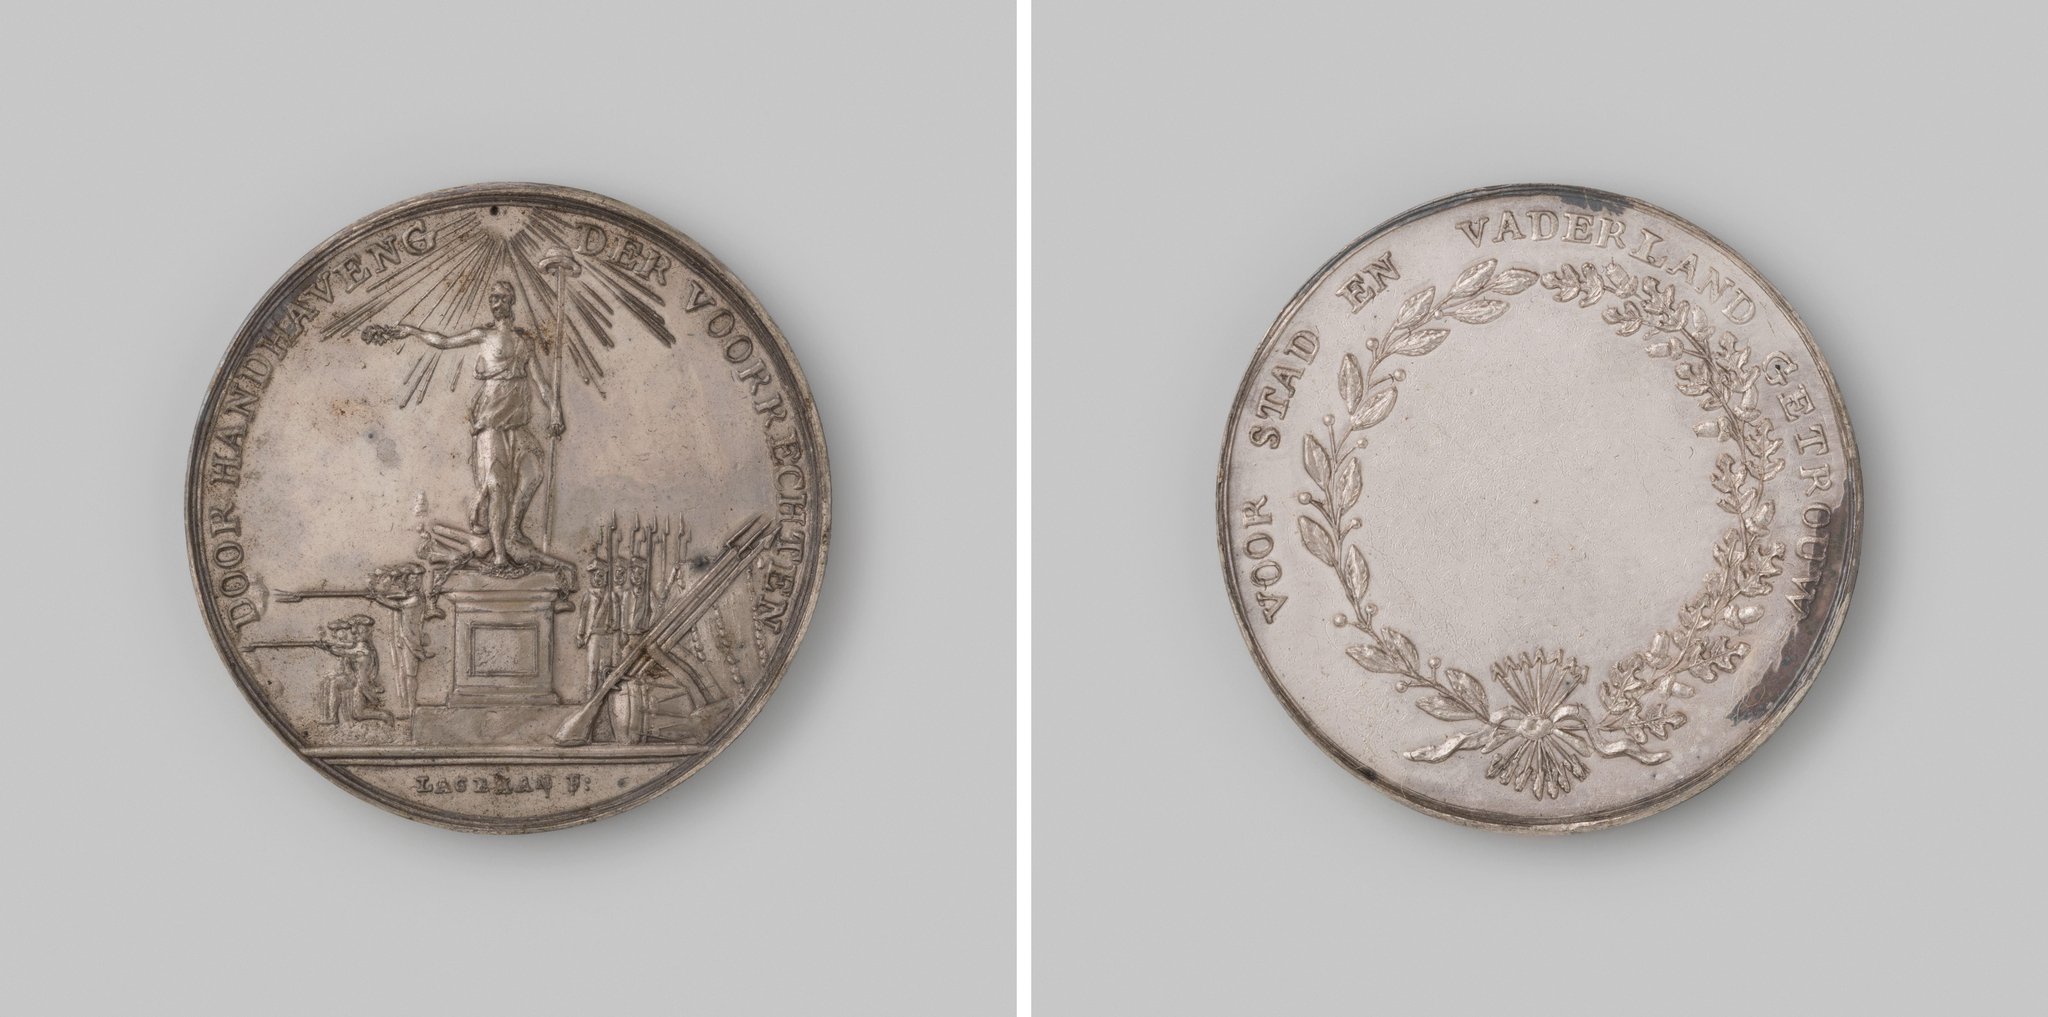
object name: history medal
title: Op de gewapende genootschappen in Nederland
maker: johannes michiel lageman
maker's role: silversmith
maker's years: 1735-1809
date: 1784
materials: silver